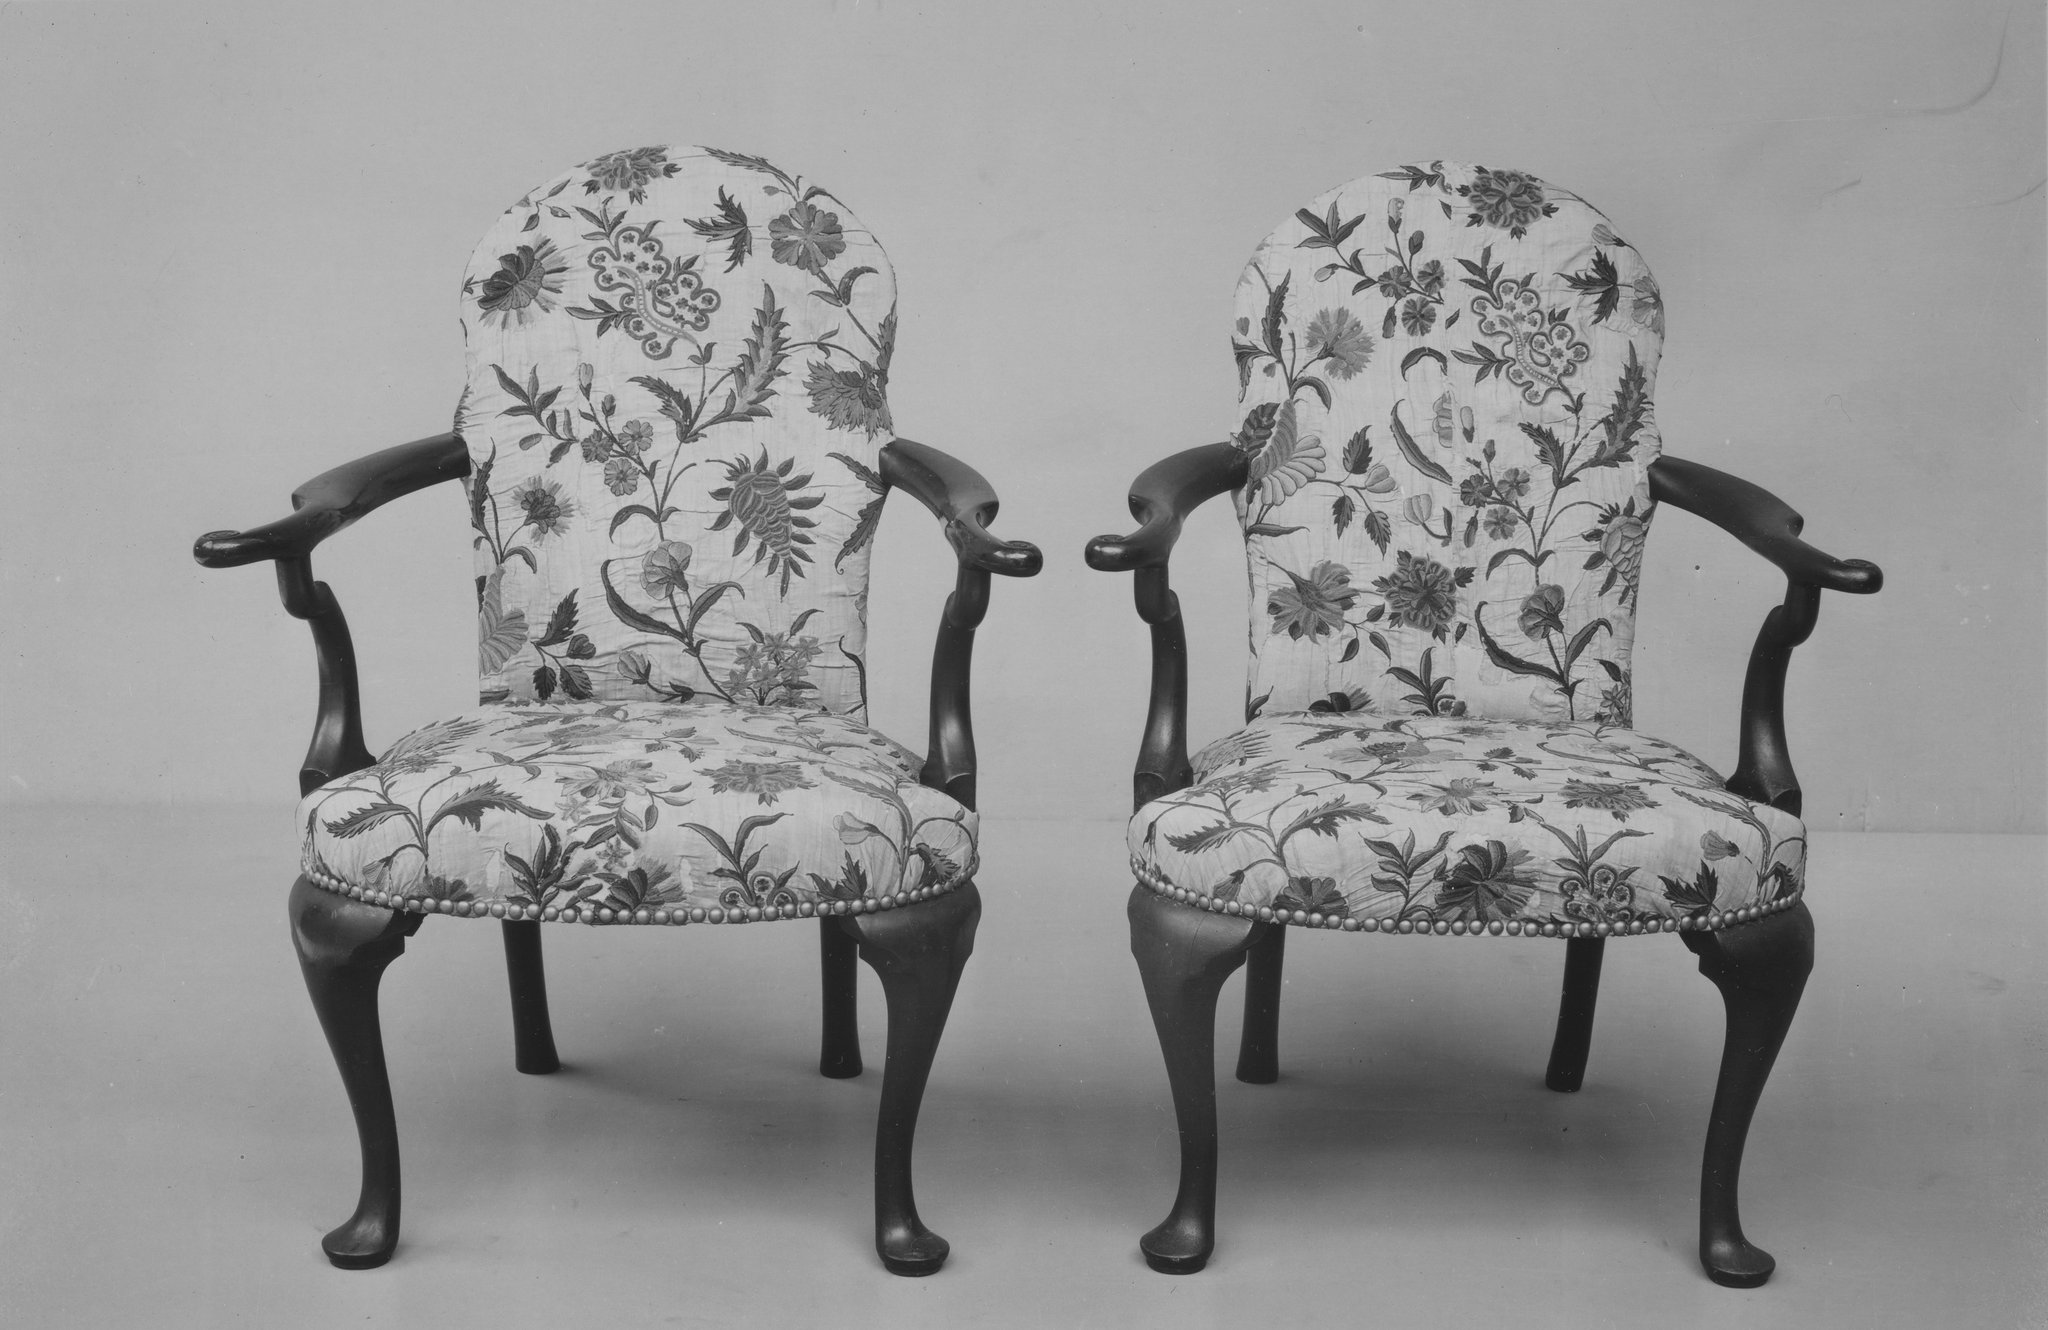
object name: armchair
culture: american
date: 1740-1760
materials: wood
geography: united states